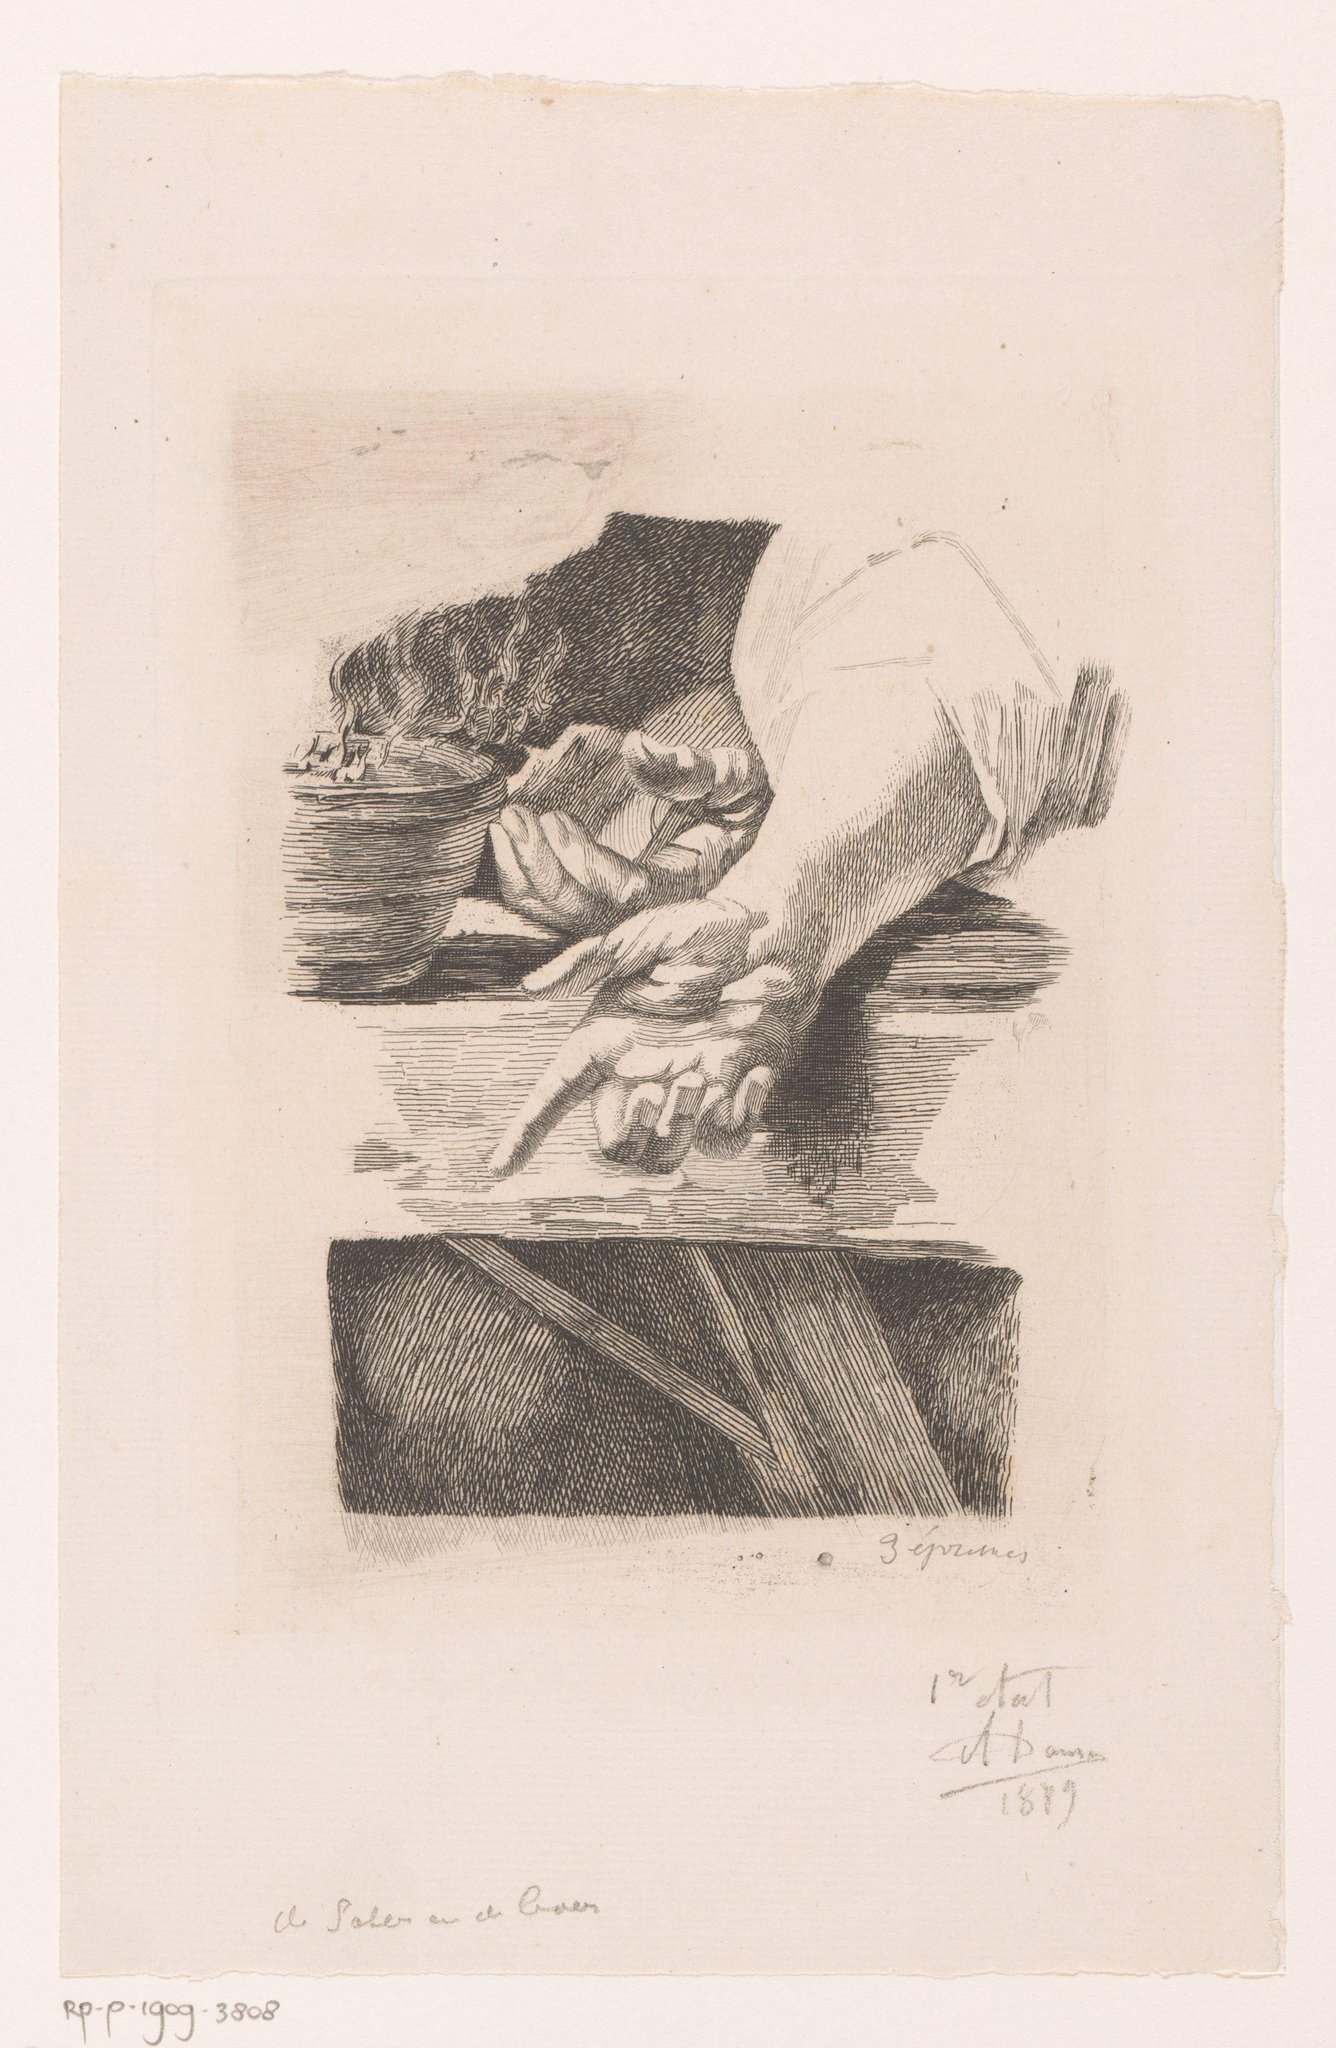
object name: print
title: Studie van twee handen op een tafel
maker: auguste danse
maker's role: print maker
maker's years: 1829-1929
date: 1879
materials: paper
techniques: drypoint, etching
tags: postures and gestures of arms and hands in general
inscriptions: annotation: ‘3 épreuves; 1er etat’, collector's mark: Lugt 2228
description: Deze prent is een detail van het schilderij "Sater en boer" door Jacob Jordaens.